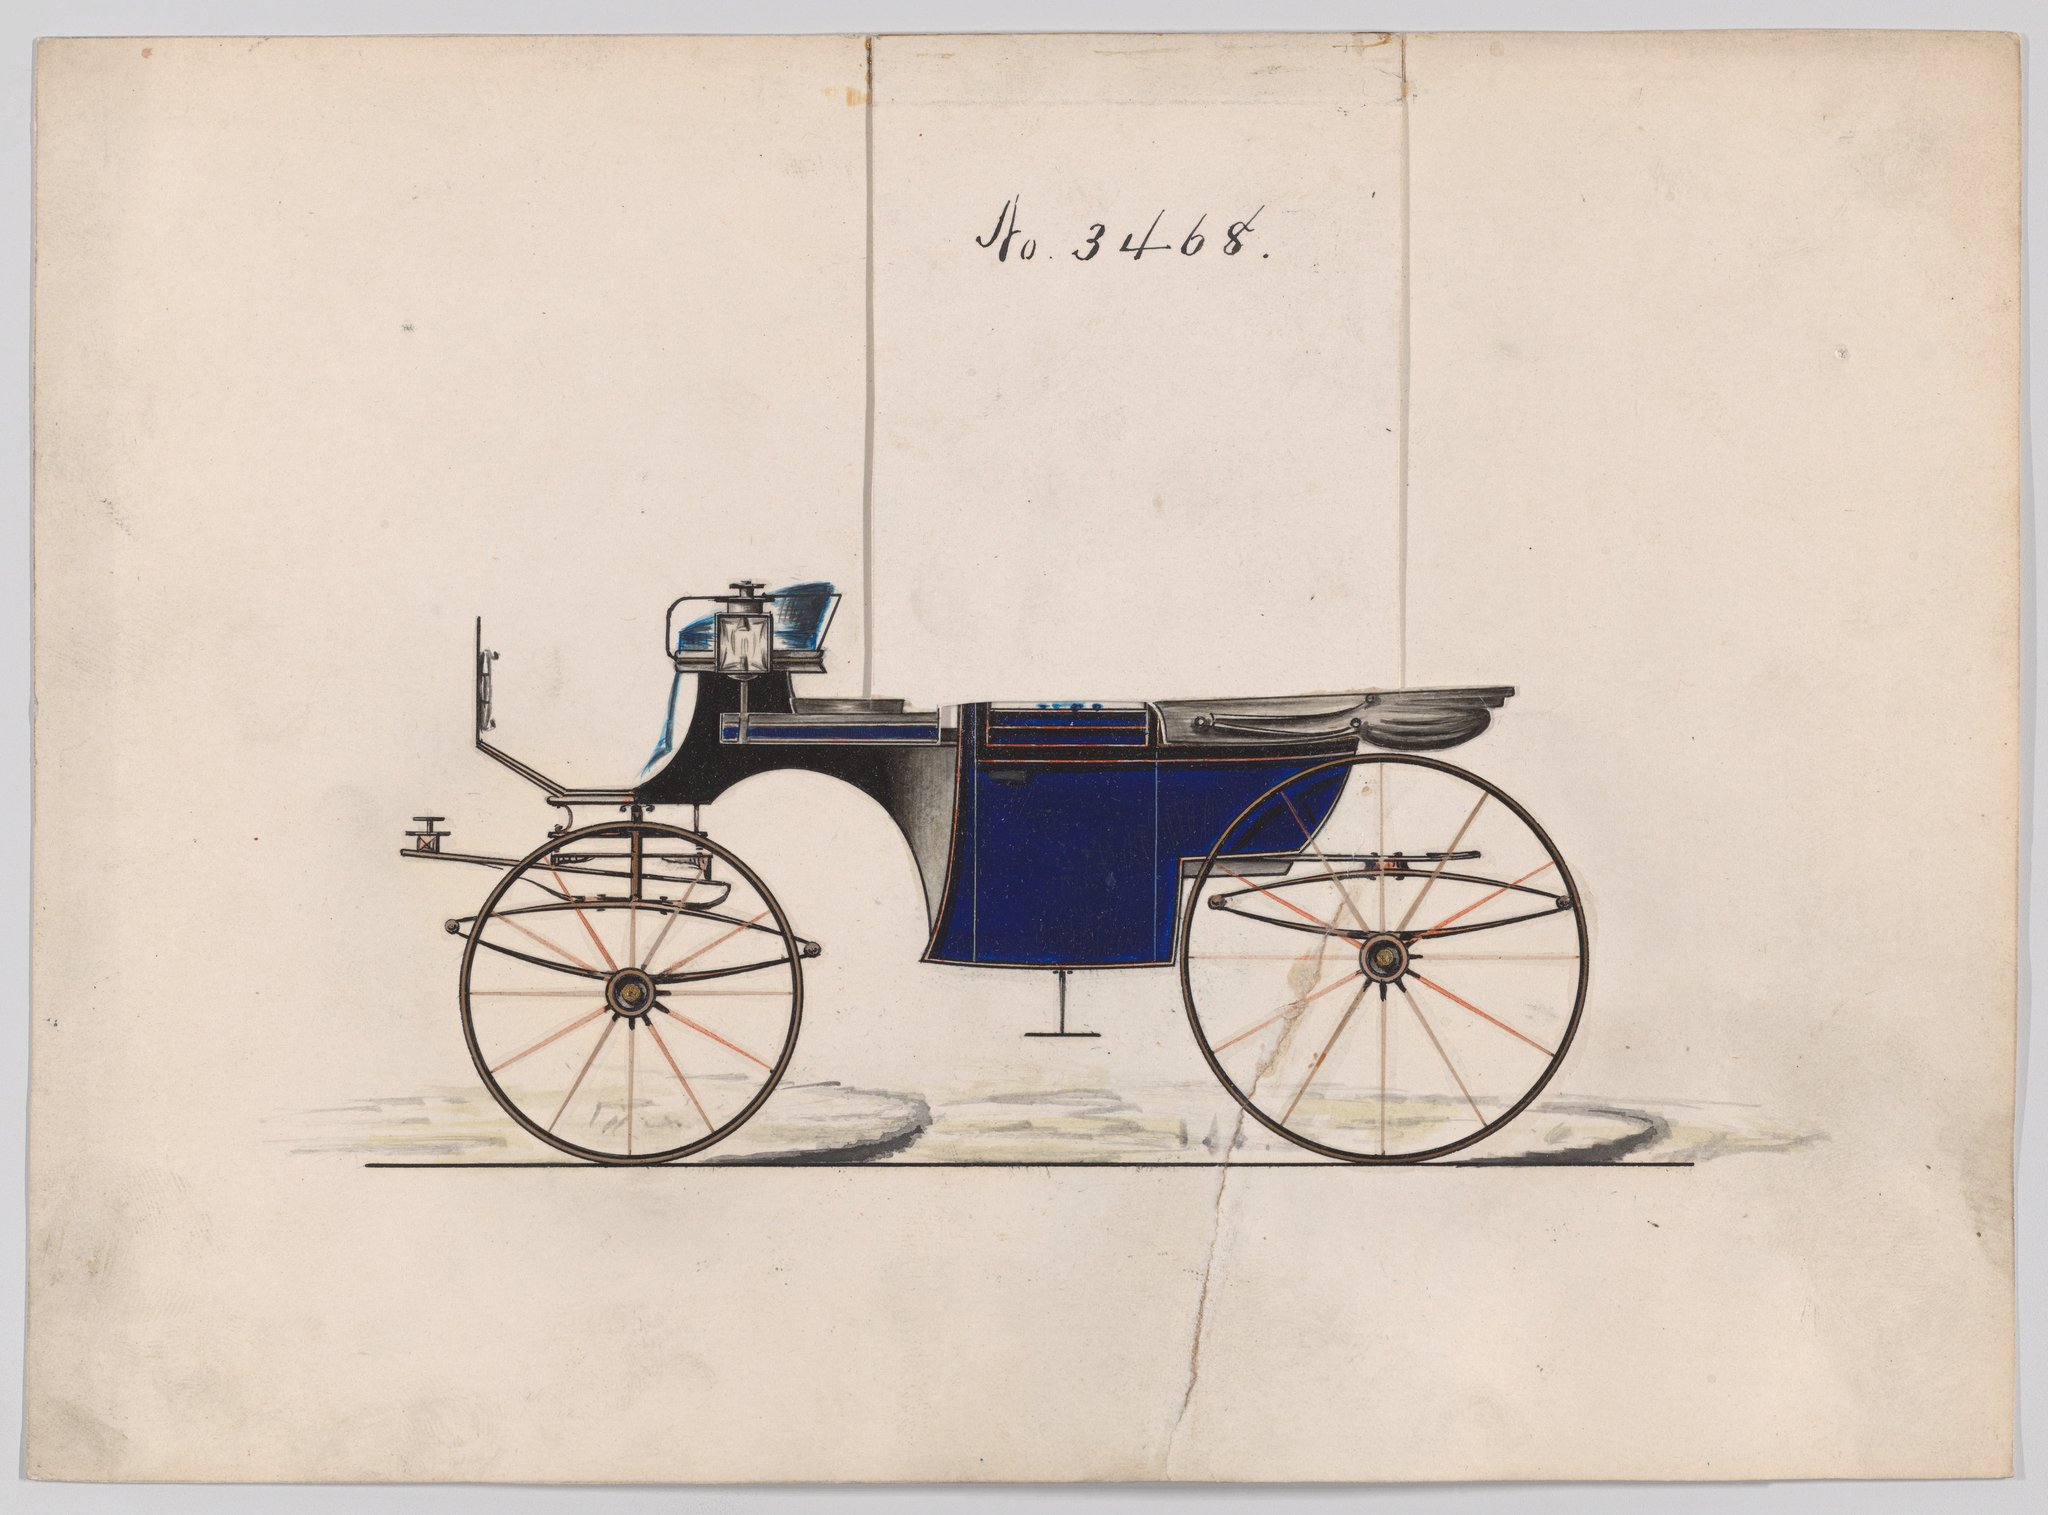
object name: drawing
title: Design for Landaulet, no. 3468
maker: brewster & co.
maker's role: manufacturer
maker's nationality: american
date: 1878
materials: gouache, gum arabic, ink, watercolor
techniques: pen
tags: carriages